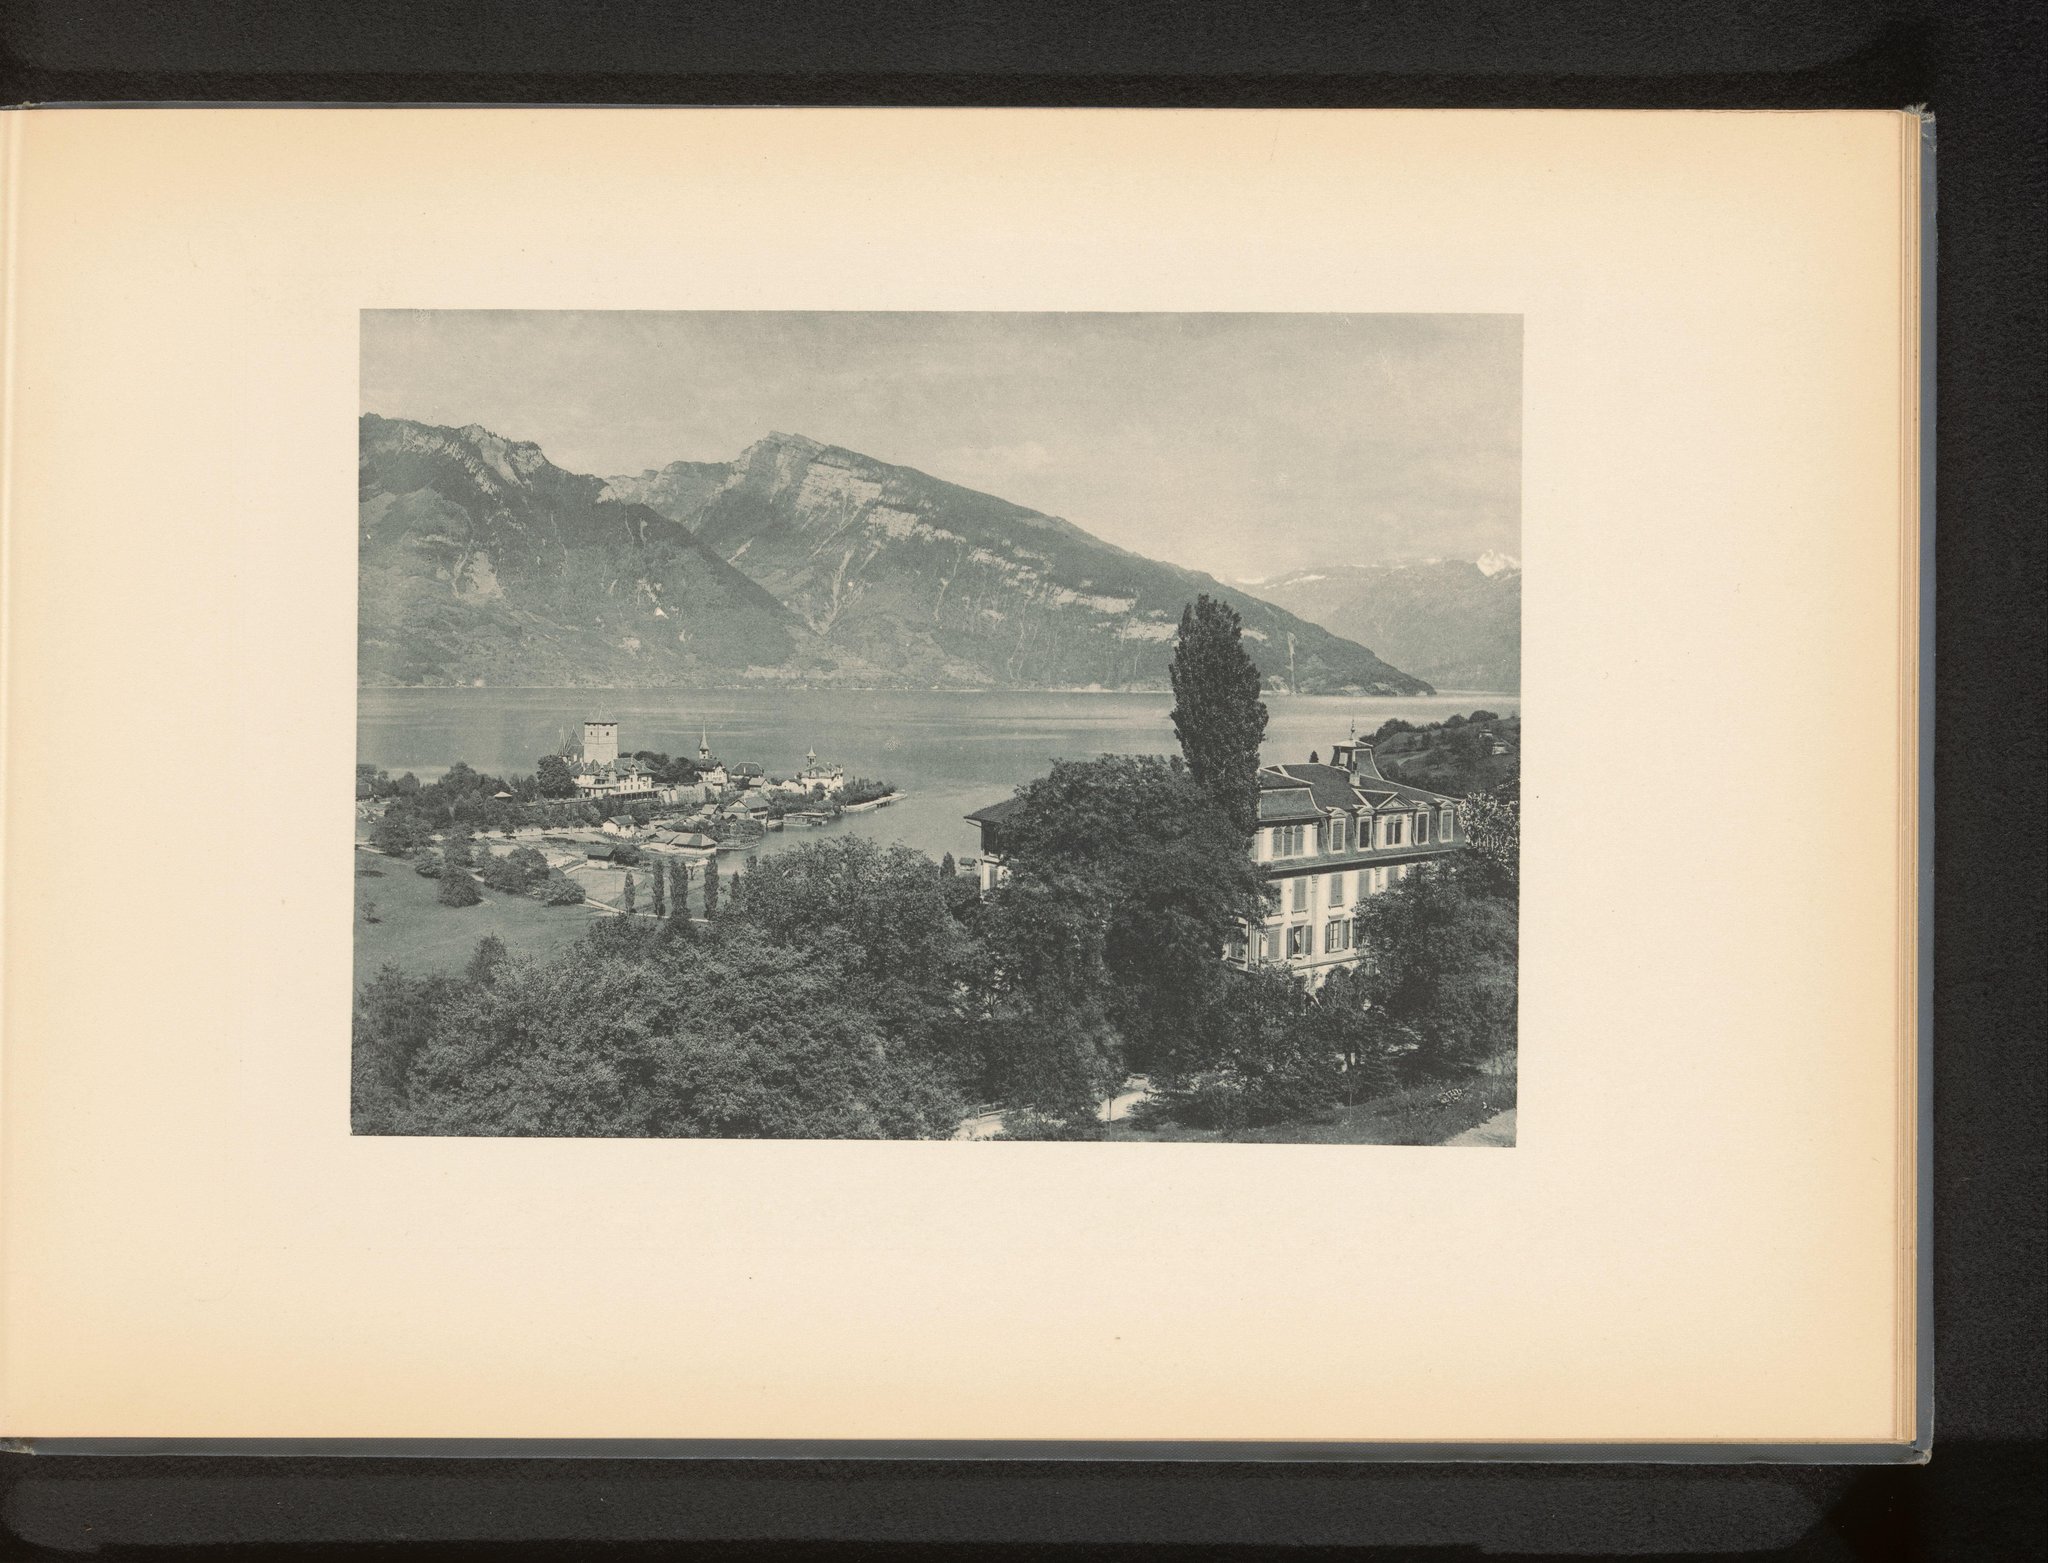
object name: photomechanical print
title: Gezicht op Spiez en het meer van Thun, Zwitserland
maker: Anonymous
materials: paper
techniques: photograph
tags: prospect of village, silhouette of village, landscapes, lake, mountains